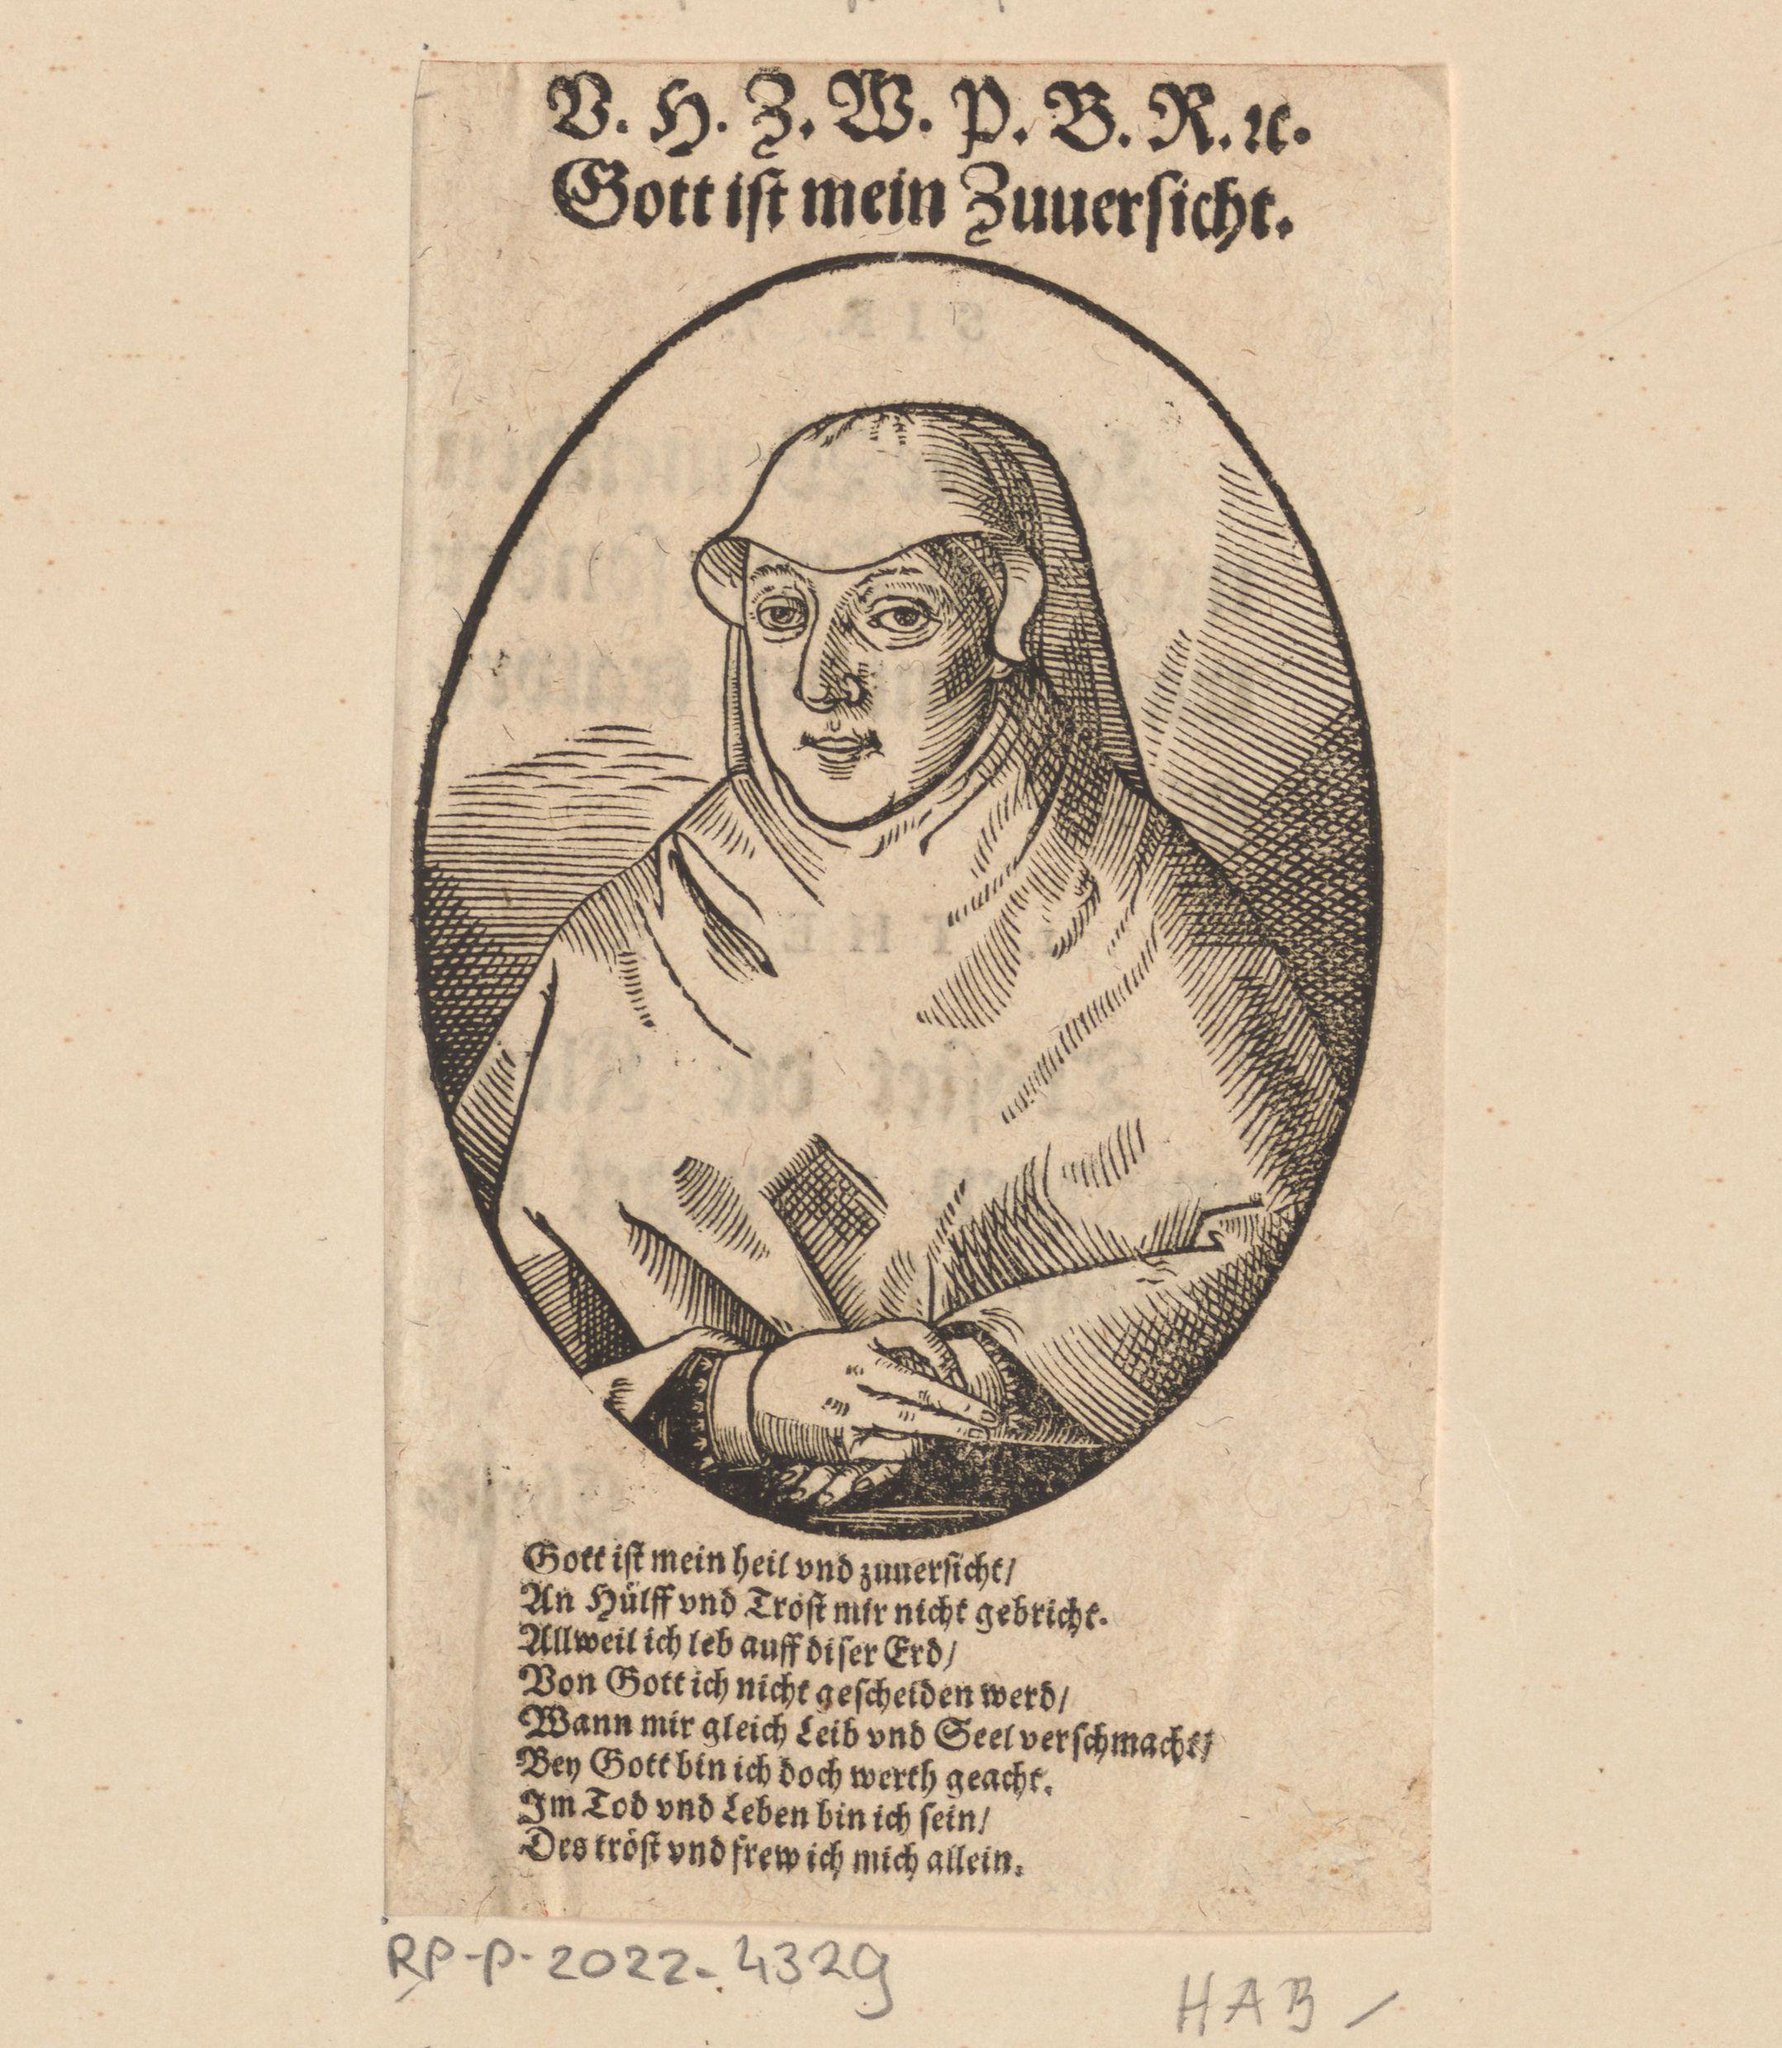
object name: book illustration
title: Portret van Ursula paltsgravin van Veldenz-Lützelstein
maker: Anonymous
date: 1590-1650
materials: paper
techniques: letterpress printing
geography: germany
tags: historical persons - bb - woman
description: Onder het portret een achtregelig vers in het Duits.